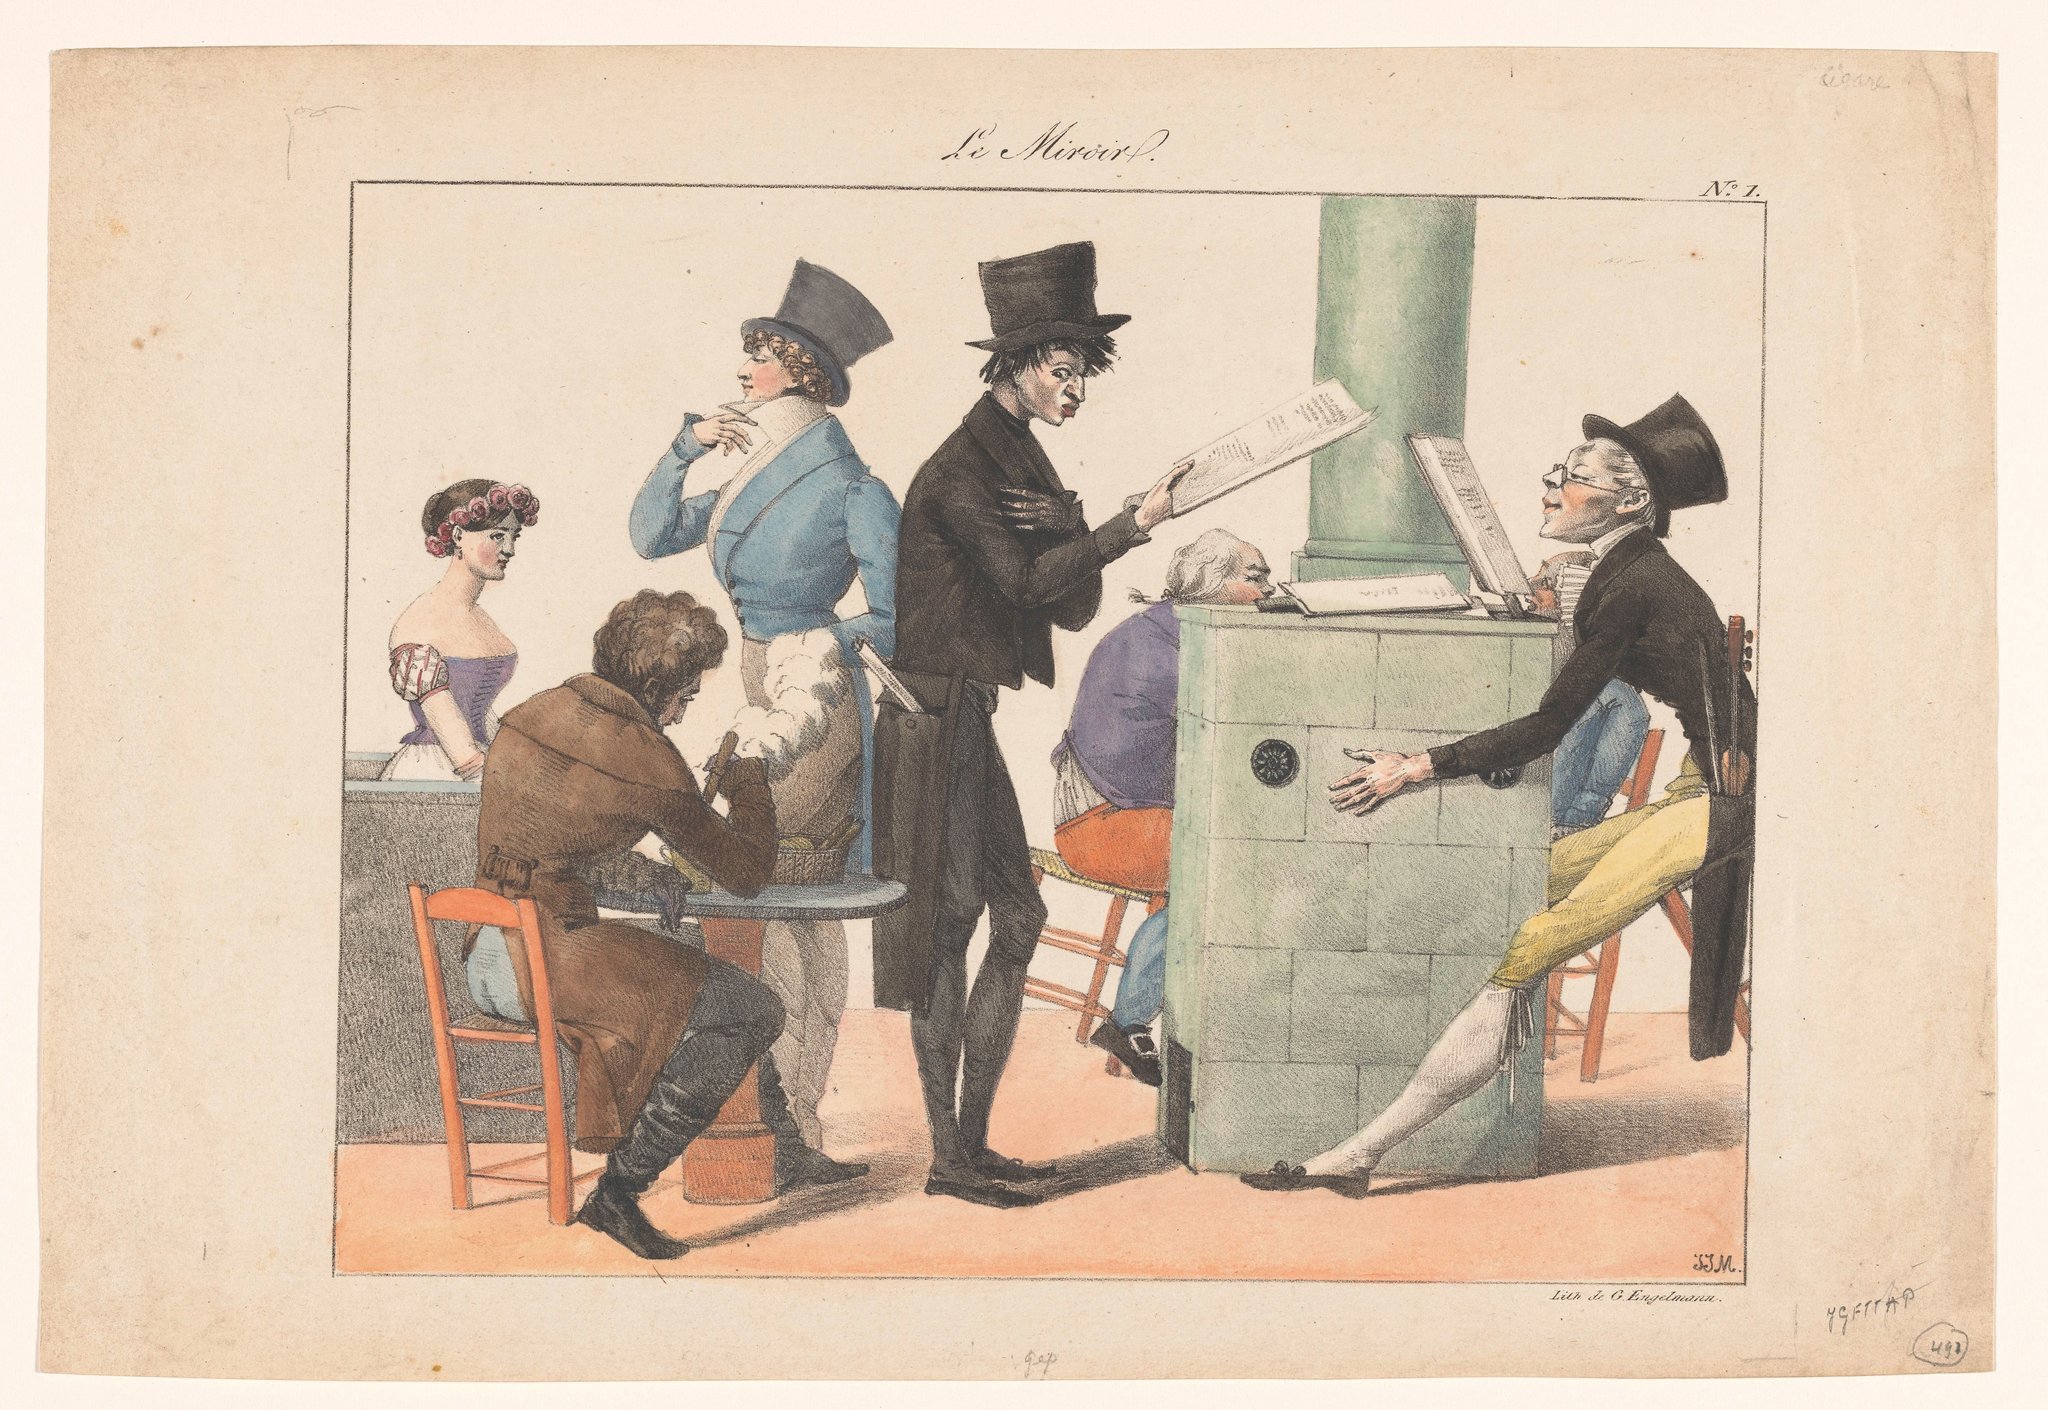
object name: print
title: Le miroir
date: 1816-1839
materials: paper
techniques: lithograph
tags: reading, cigar, newspaper, news-sheet, heating stove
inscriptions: collector's mark: Lugt 2228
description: Rond een kachel staan twee mannen die de krant lezen. De rechter heeft een viool met strijkstok in zijn jaszak. Aan een tafel zit een man een sigaar te roken. In de achtergrond nog drie mannen en een vrouw. Rechtsboven genummerd: No. 1.